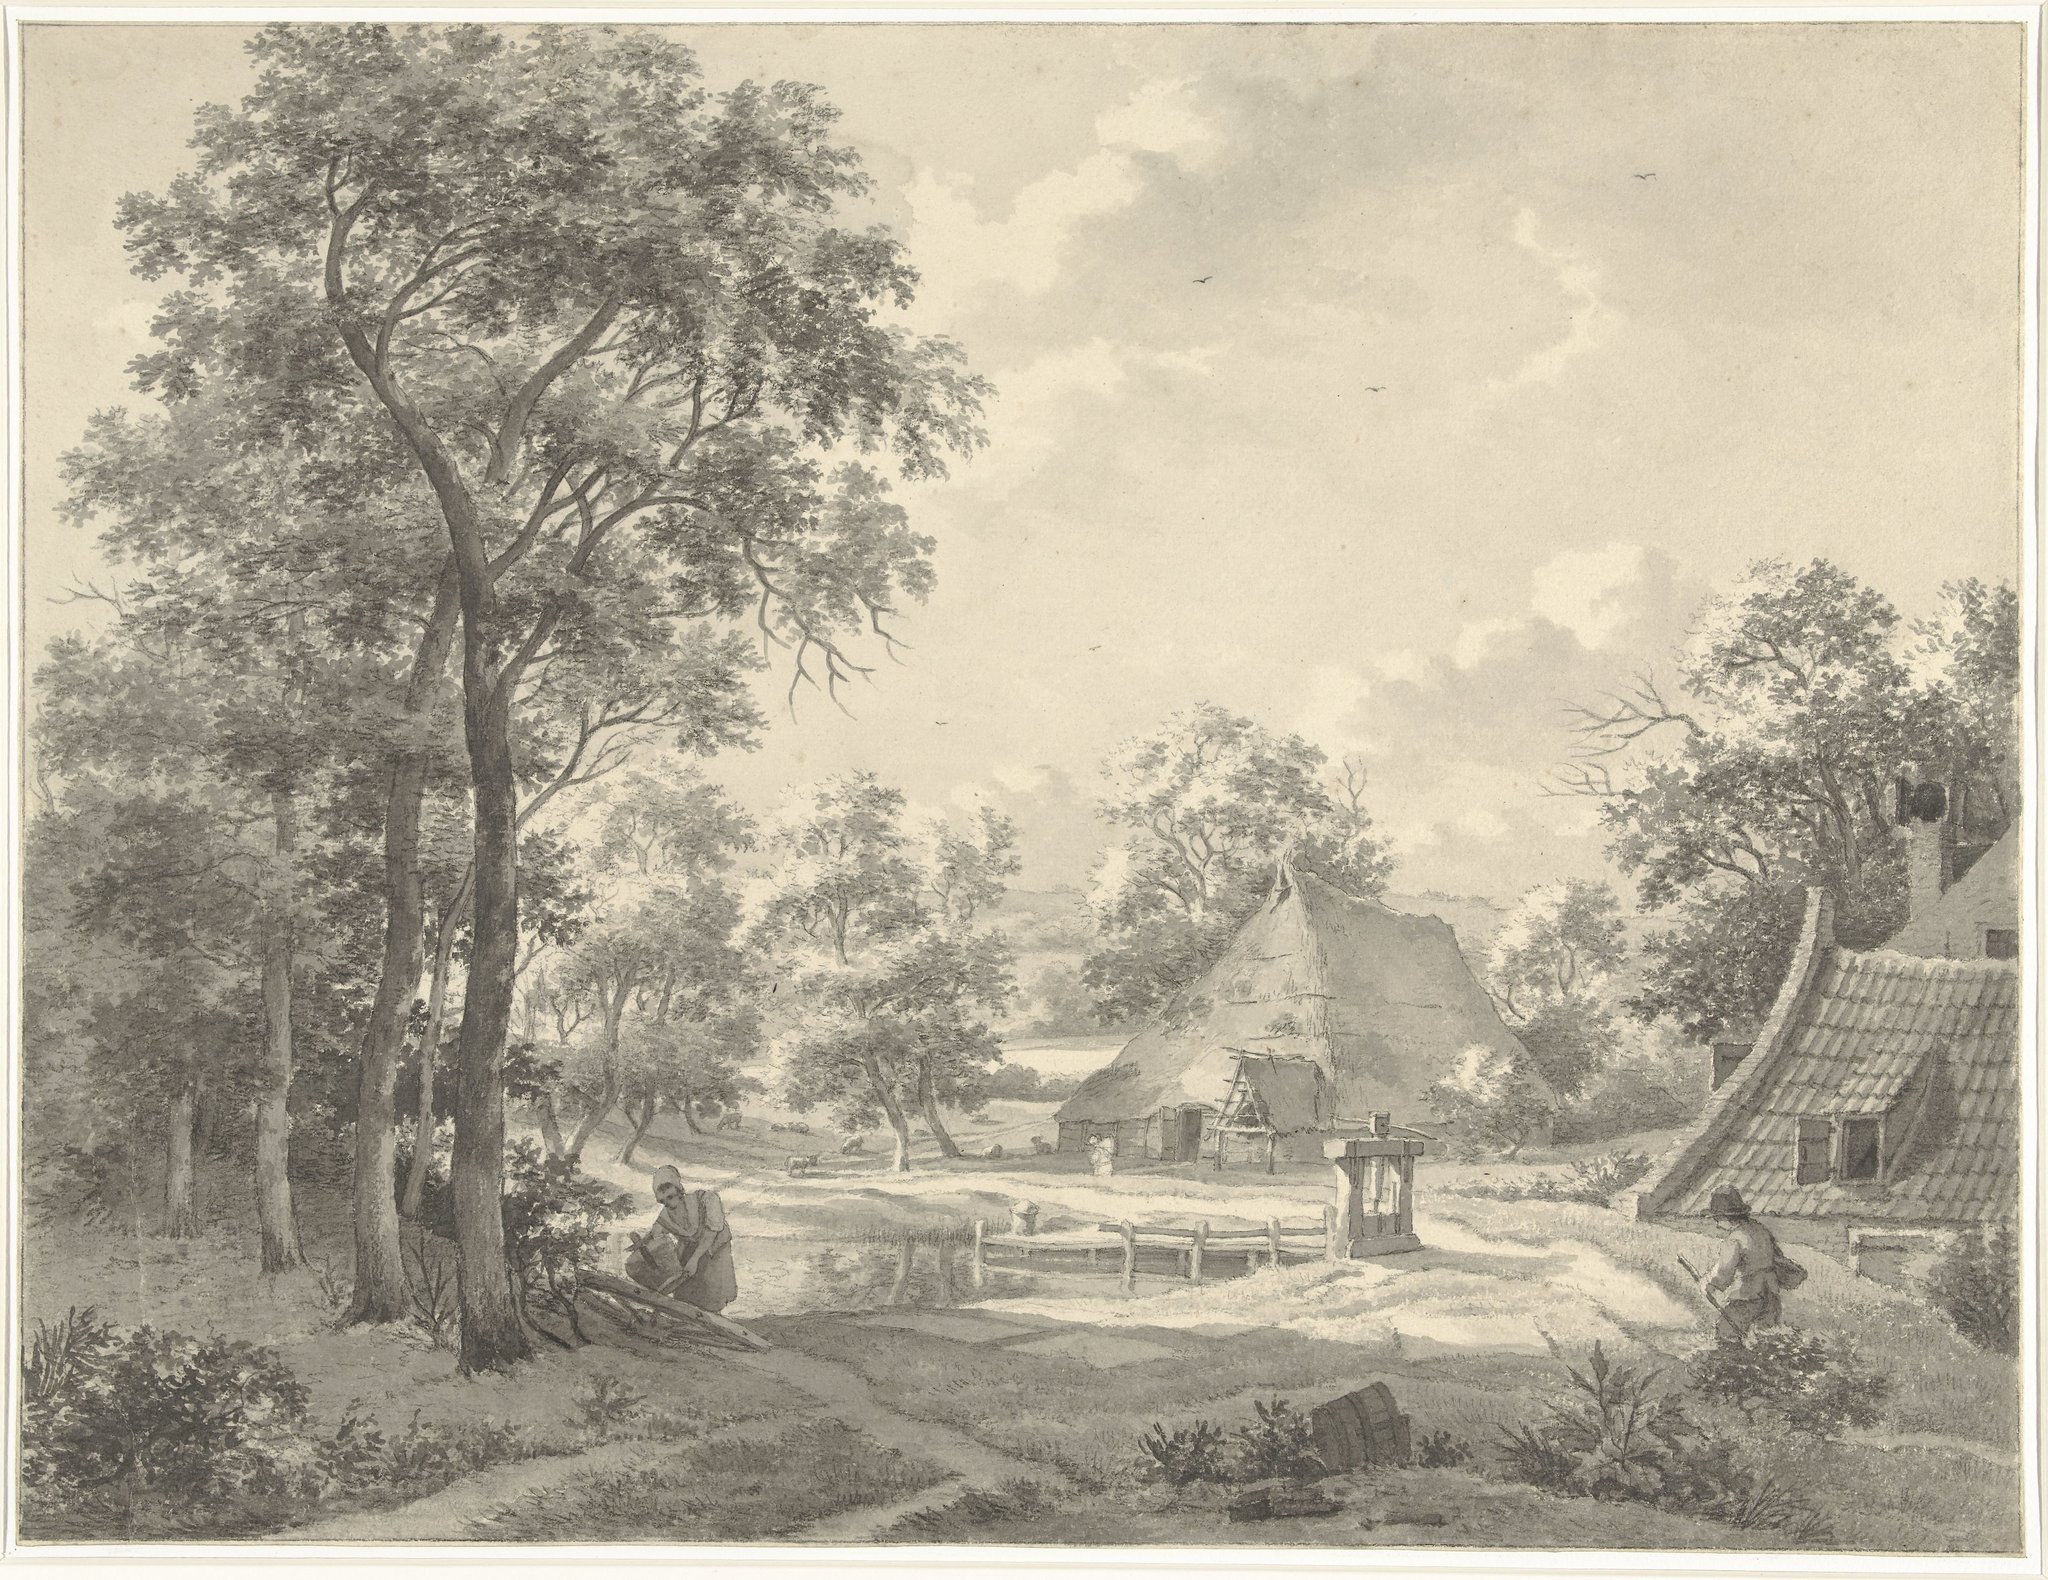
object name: drawing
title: Boerenhofstede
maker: daniël kerkhoff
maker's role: draughtsman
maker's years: 1766-1821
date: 1812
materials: chalk, paper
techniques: brush